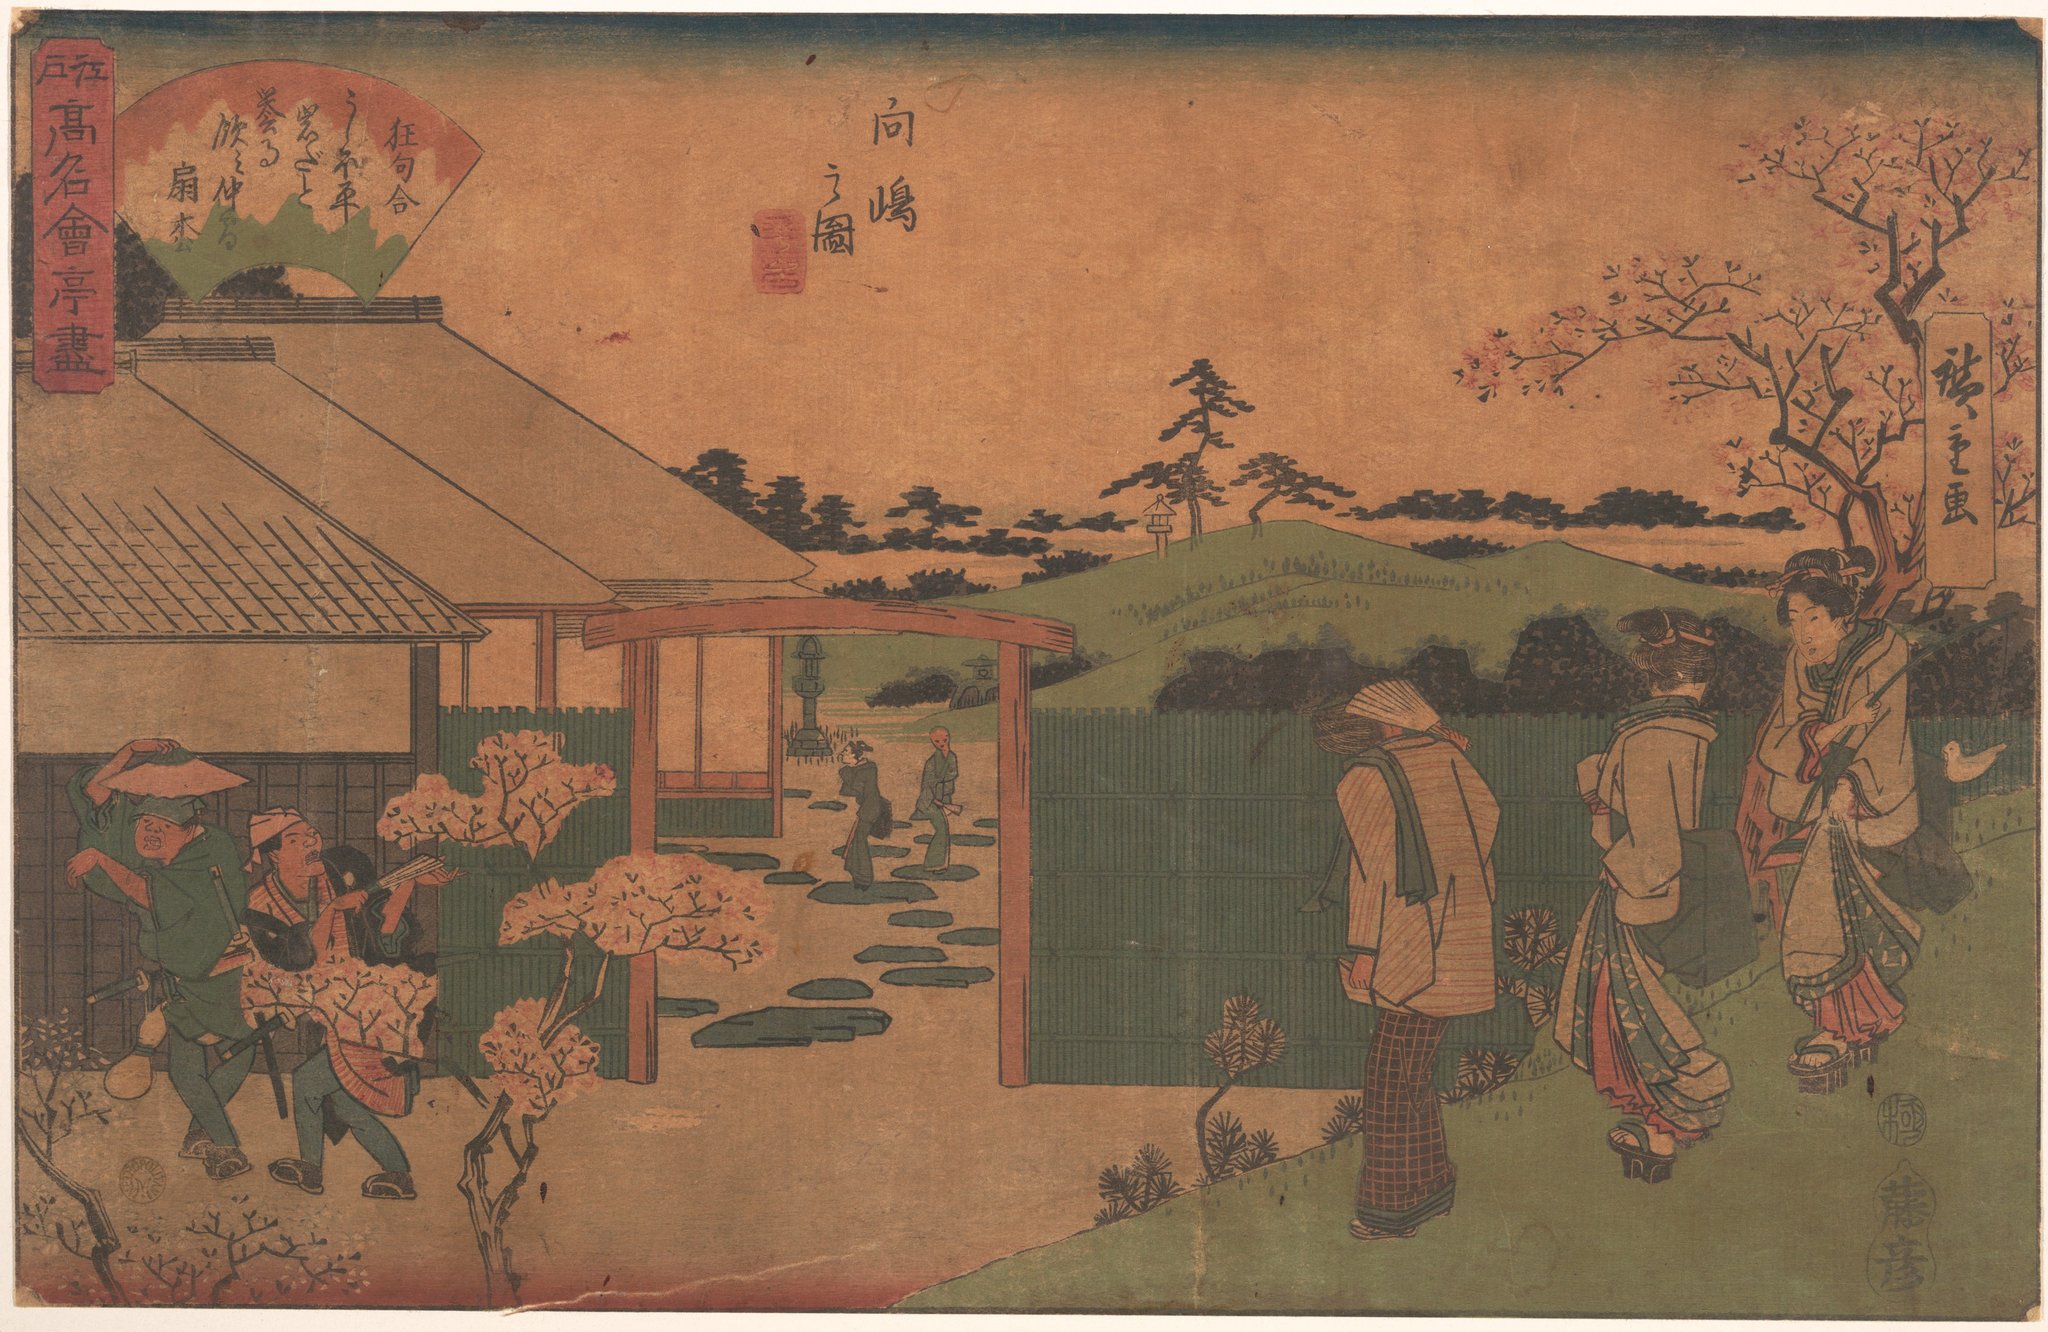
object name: print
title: Mukojima no Zu (Hira-Iwa)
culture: japanese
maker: utagawa hiroshige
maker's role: artist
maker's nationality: japanese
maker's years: 1797-1858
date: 1840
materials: ink, paper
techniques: woodblock print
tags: gates,houses,men,women,trees